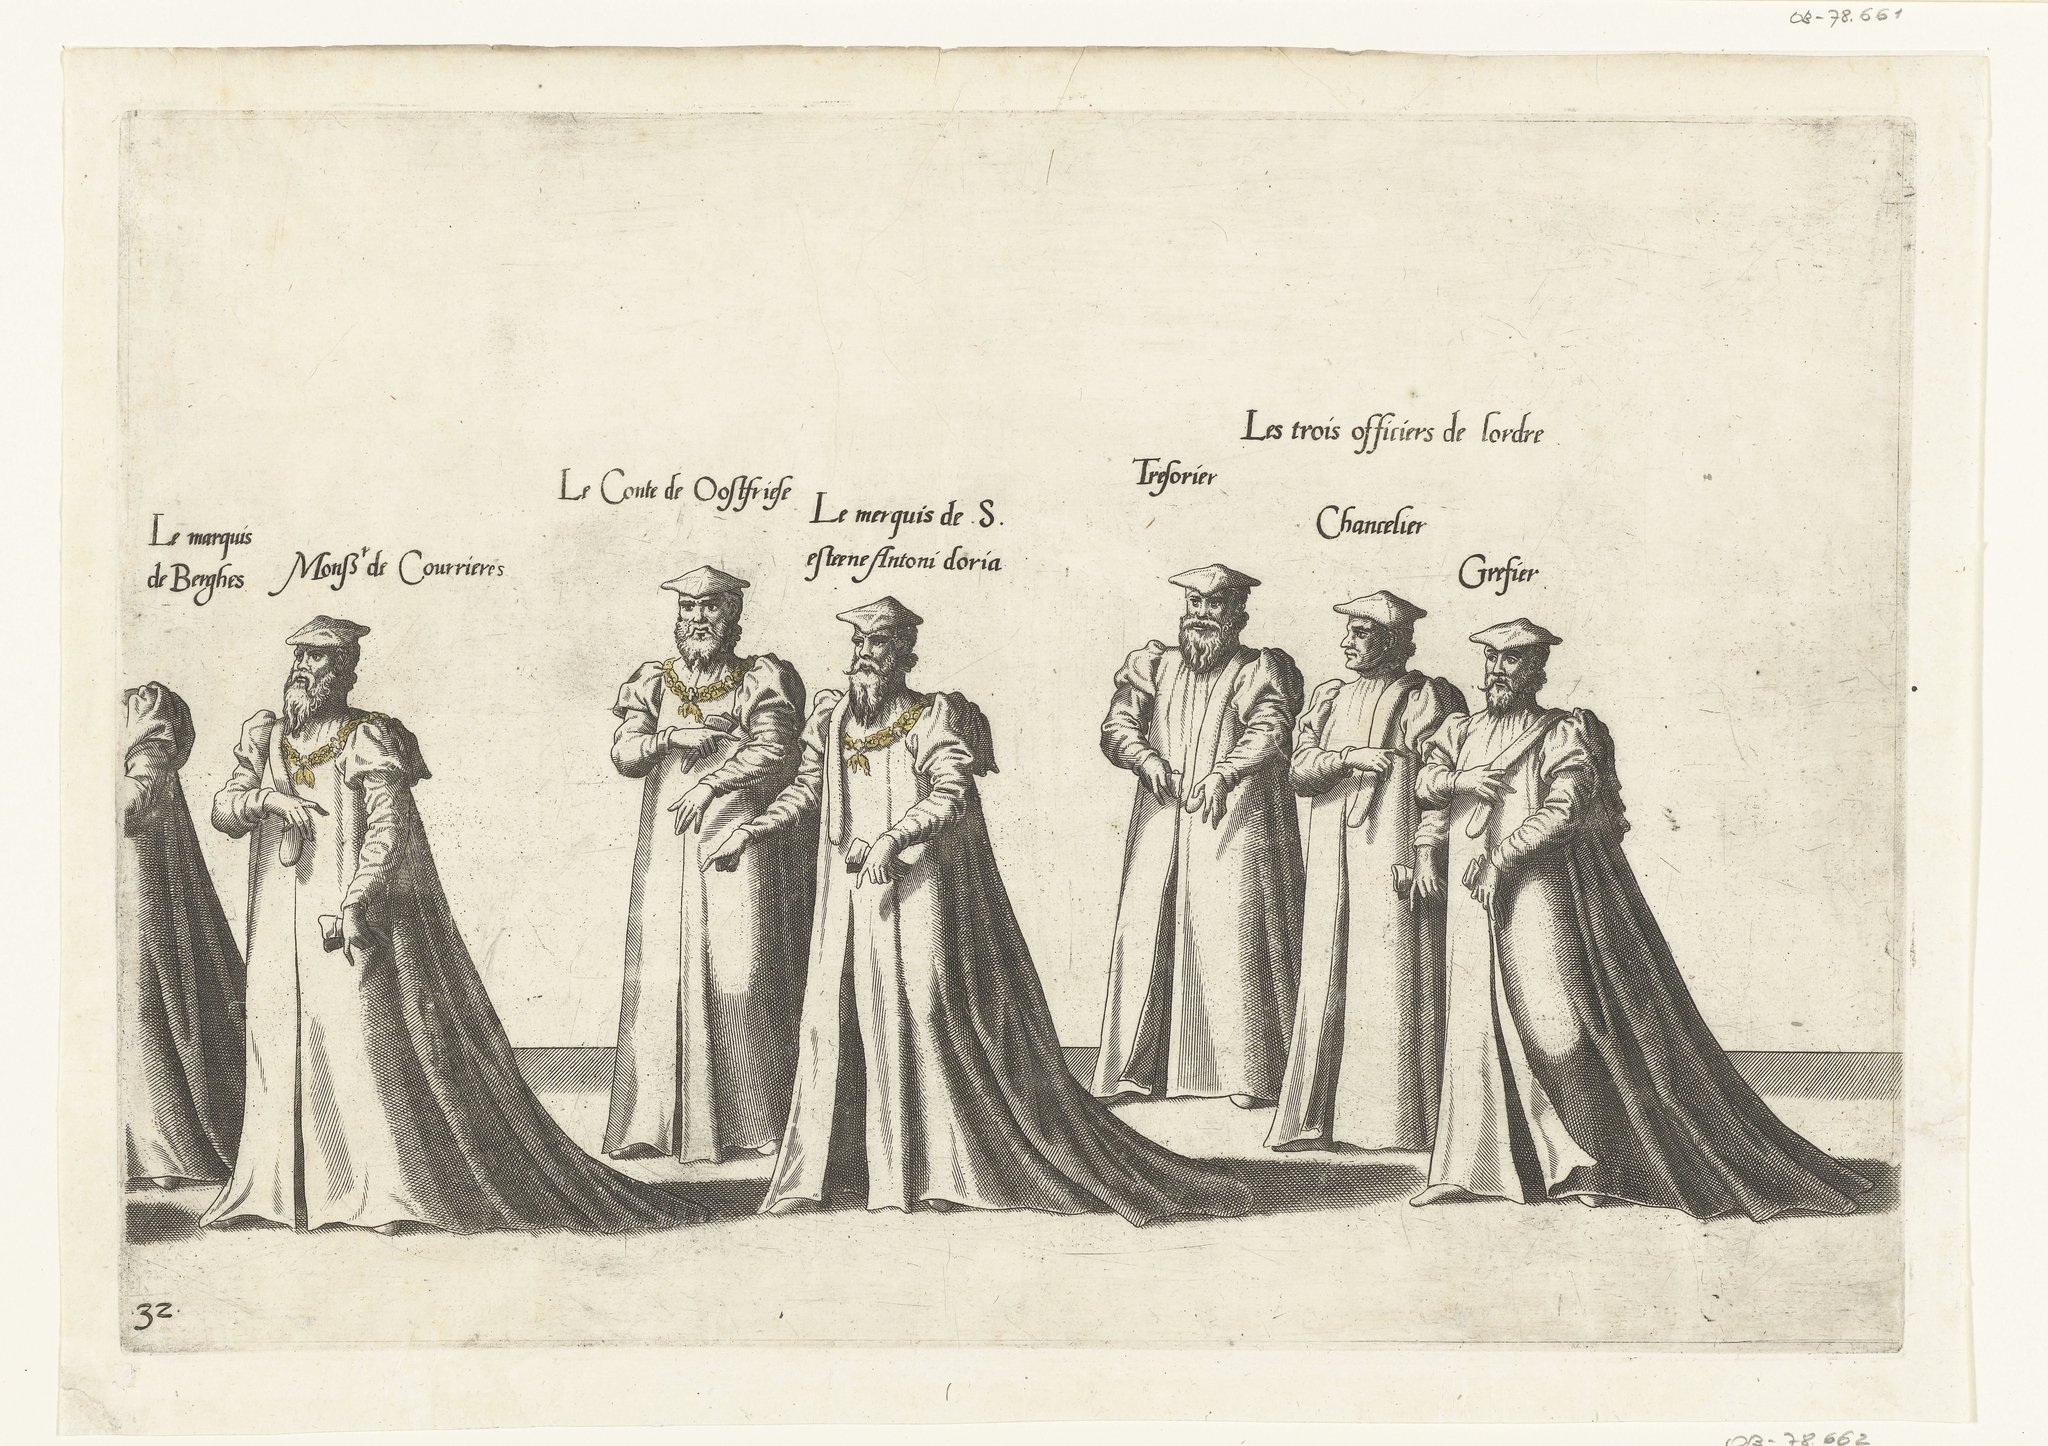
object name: print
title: Begrafenisoptocht van keizer Karel V, 1558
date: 1559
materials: paper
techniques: engraving, etching, hand coloring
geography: southern netherlands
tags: ghent, charles v (holy roman emperor and king of spain), cortege, funeral procession, knighthood order of the golden fleece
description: Drie vliesridders en drie officieren van de orde die deelnemen aan de optocht. Onderdeel van de prentreeks van de Begrafenisoptocht van keizer Karel V op 29 december 1558 te Brussel.